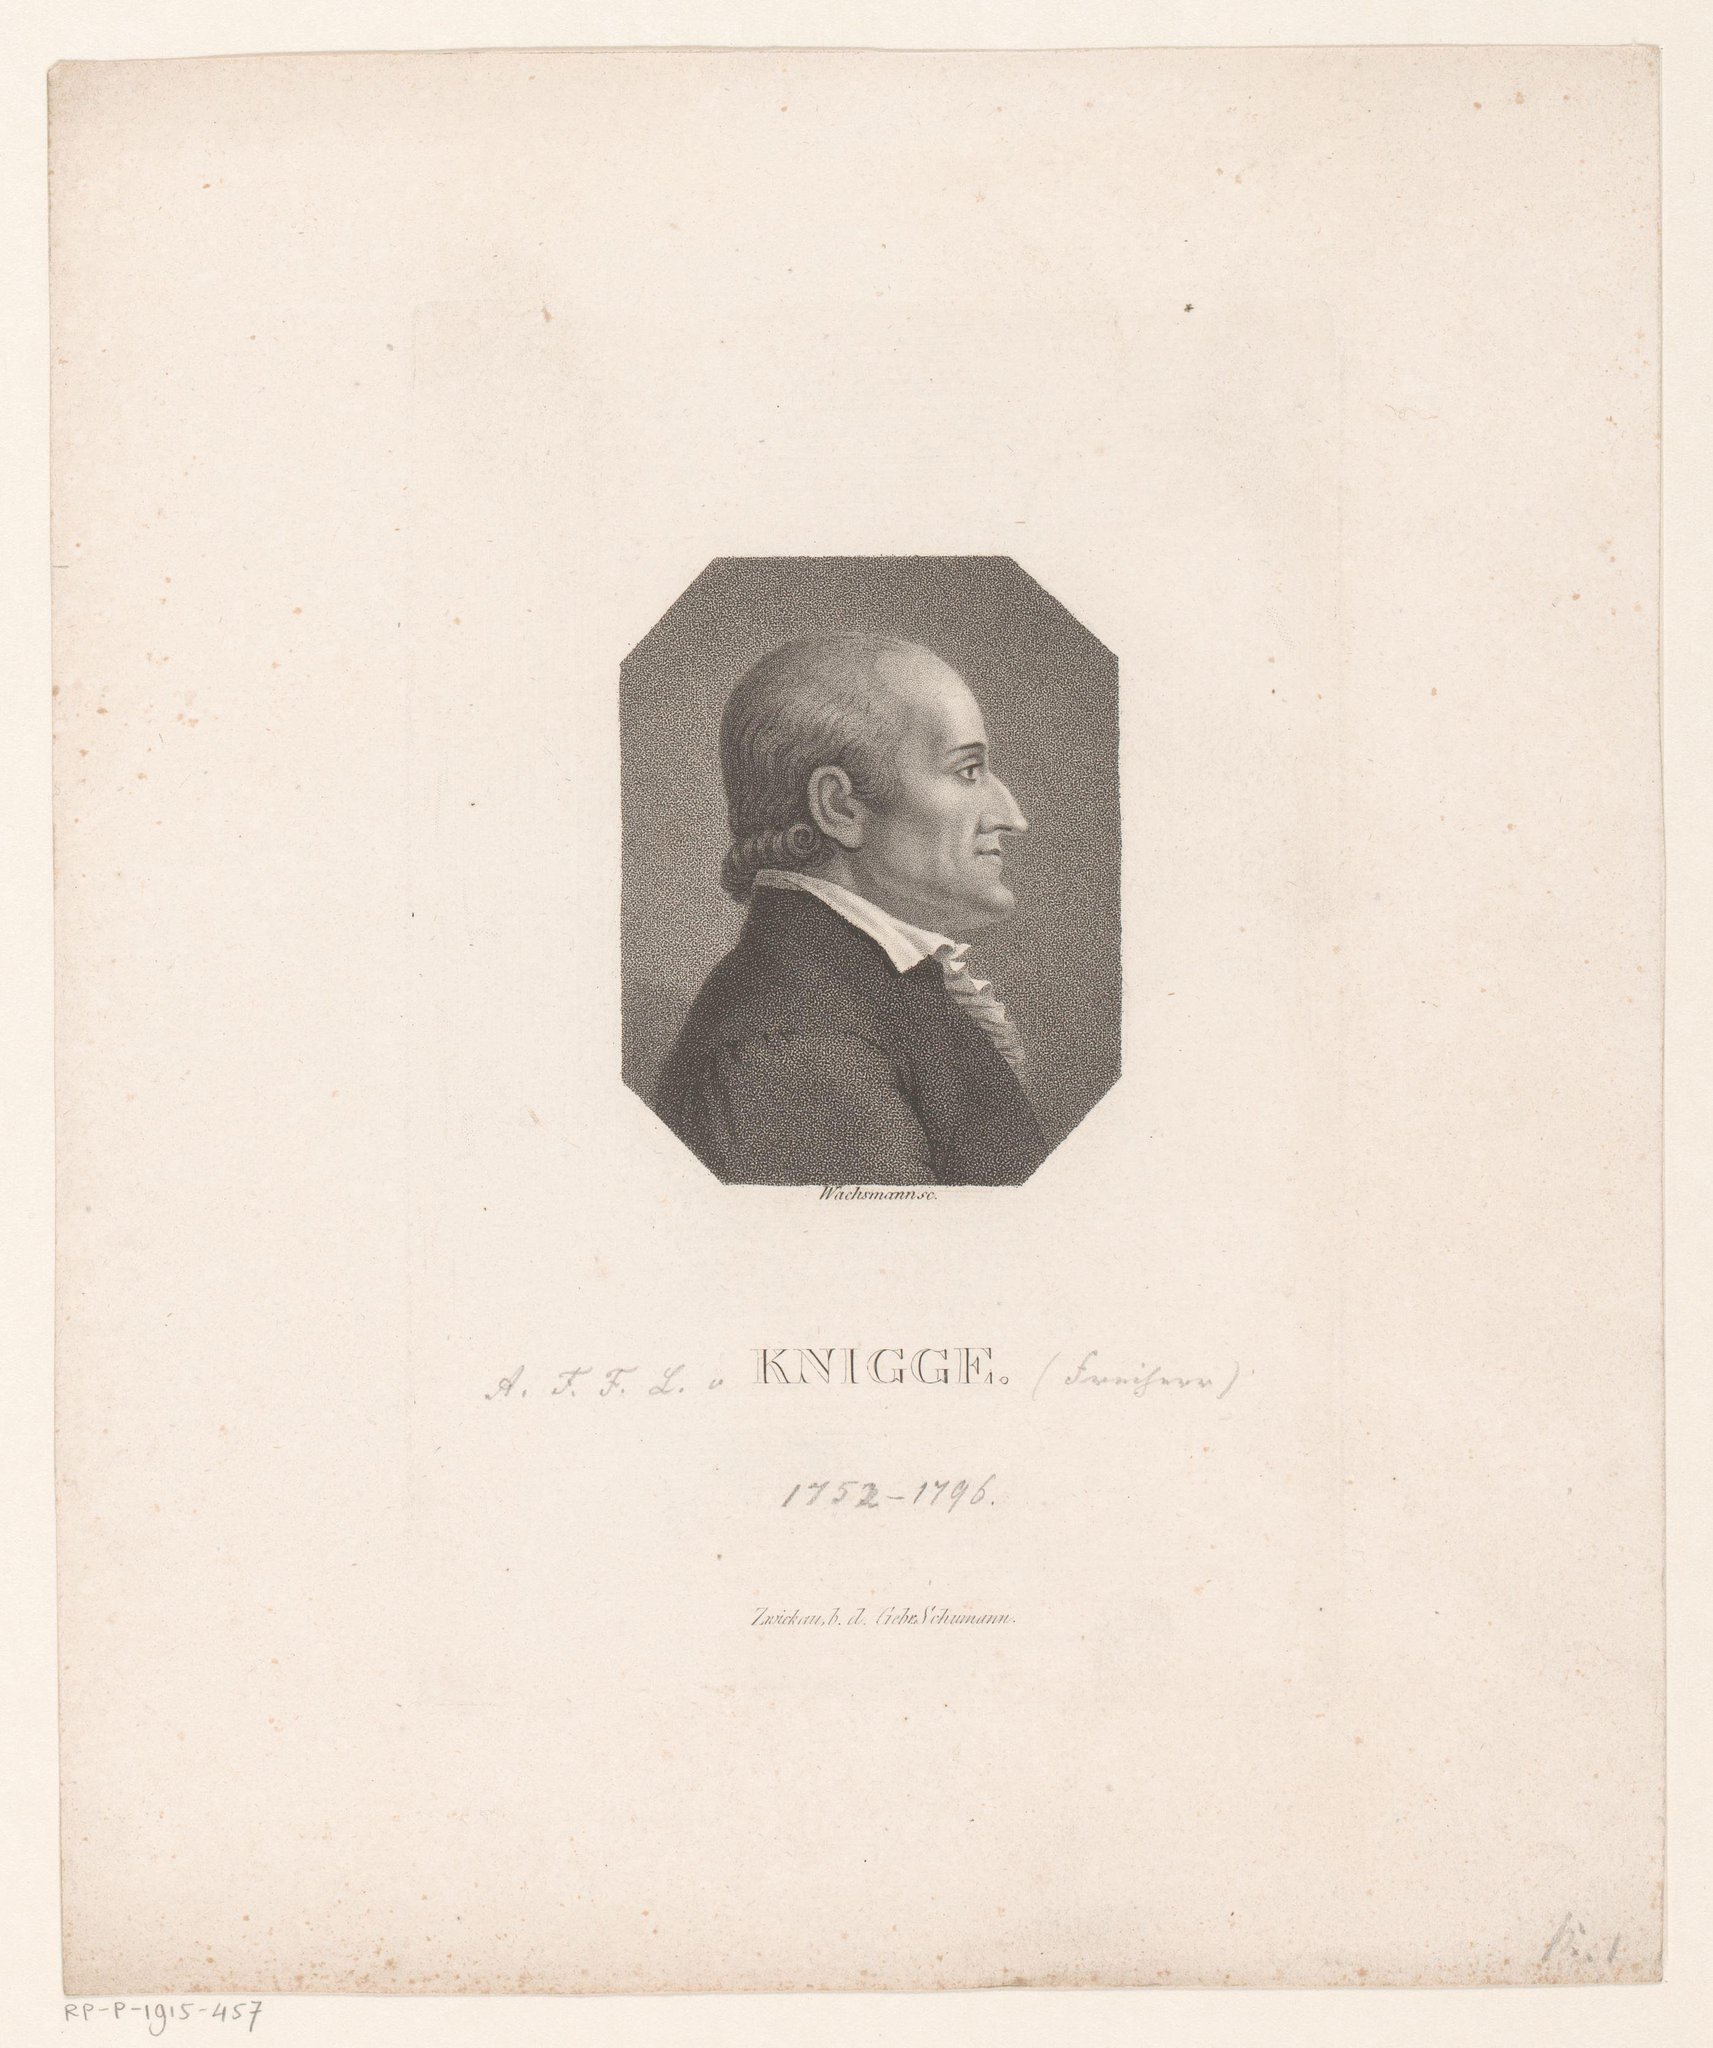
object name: print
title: Portret van Adolph Knigge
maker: anton wachsmann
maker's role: print maker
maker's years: 1765-1836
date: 1818-1832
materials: paper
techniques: engraving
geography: zwickau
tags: historical persons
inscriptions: collector's mark: Lugt 2228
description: Prent gebruikt door de serie 'Bildnisse der berühmtesten Menschen aller Völker und Zeiten', uitgegeven door de gebroeders Schumann in 1818-1832 te Zwickau.